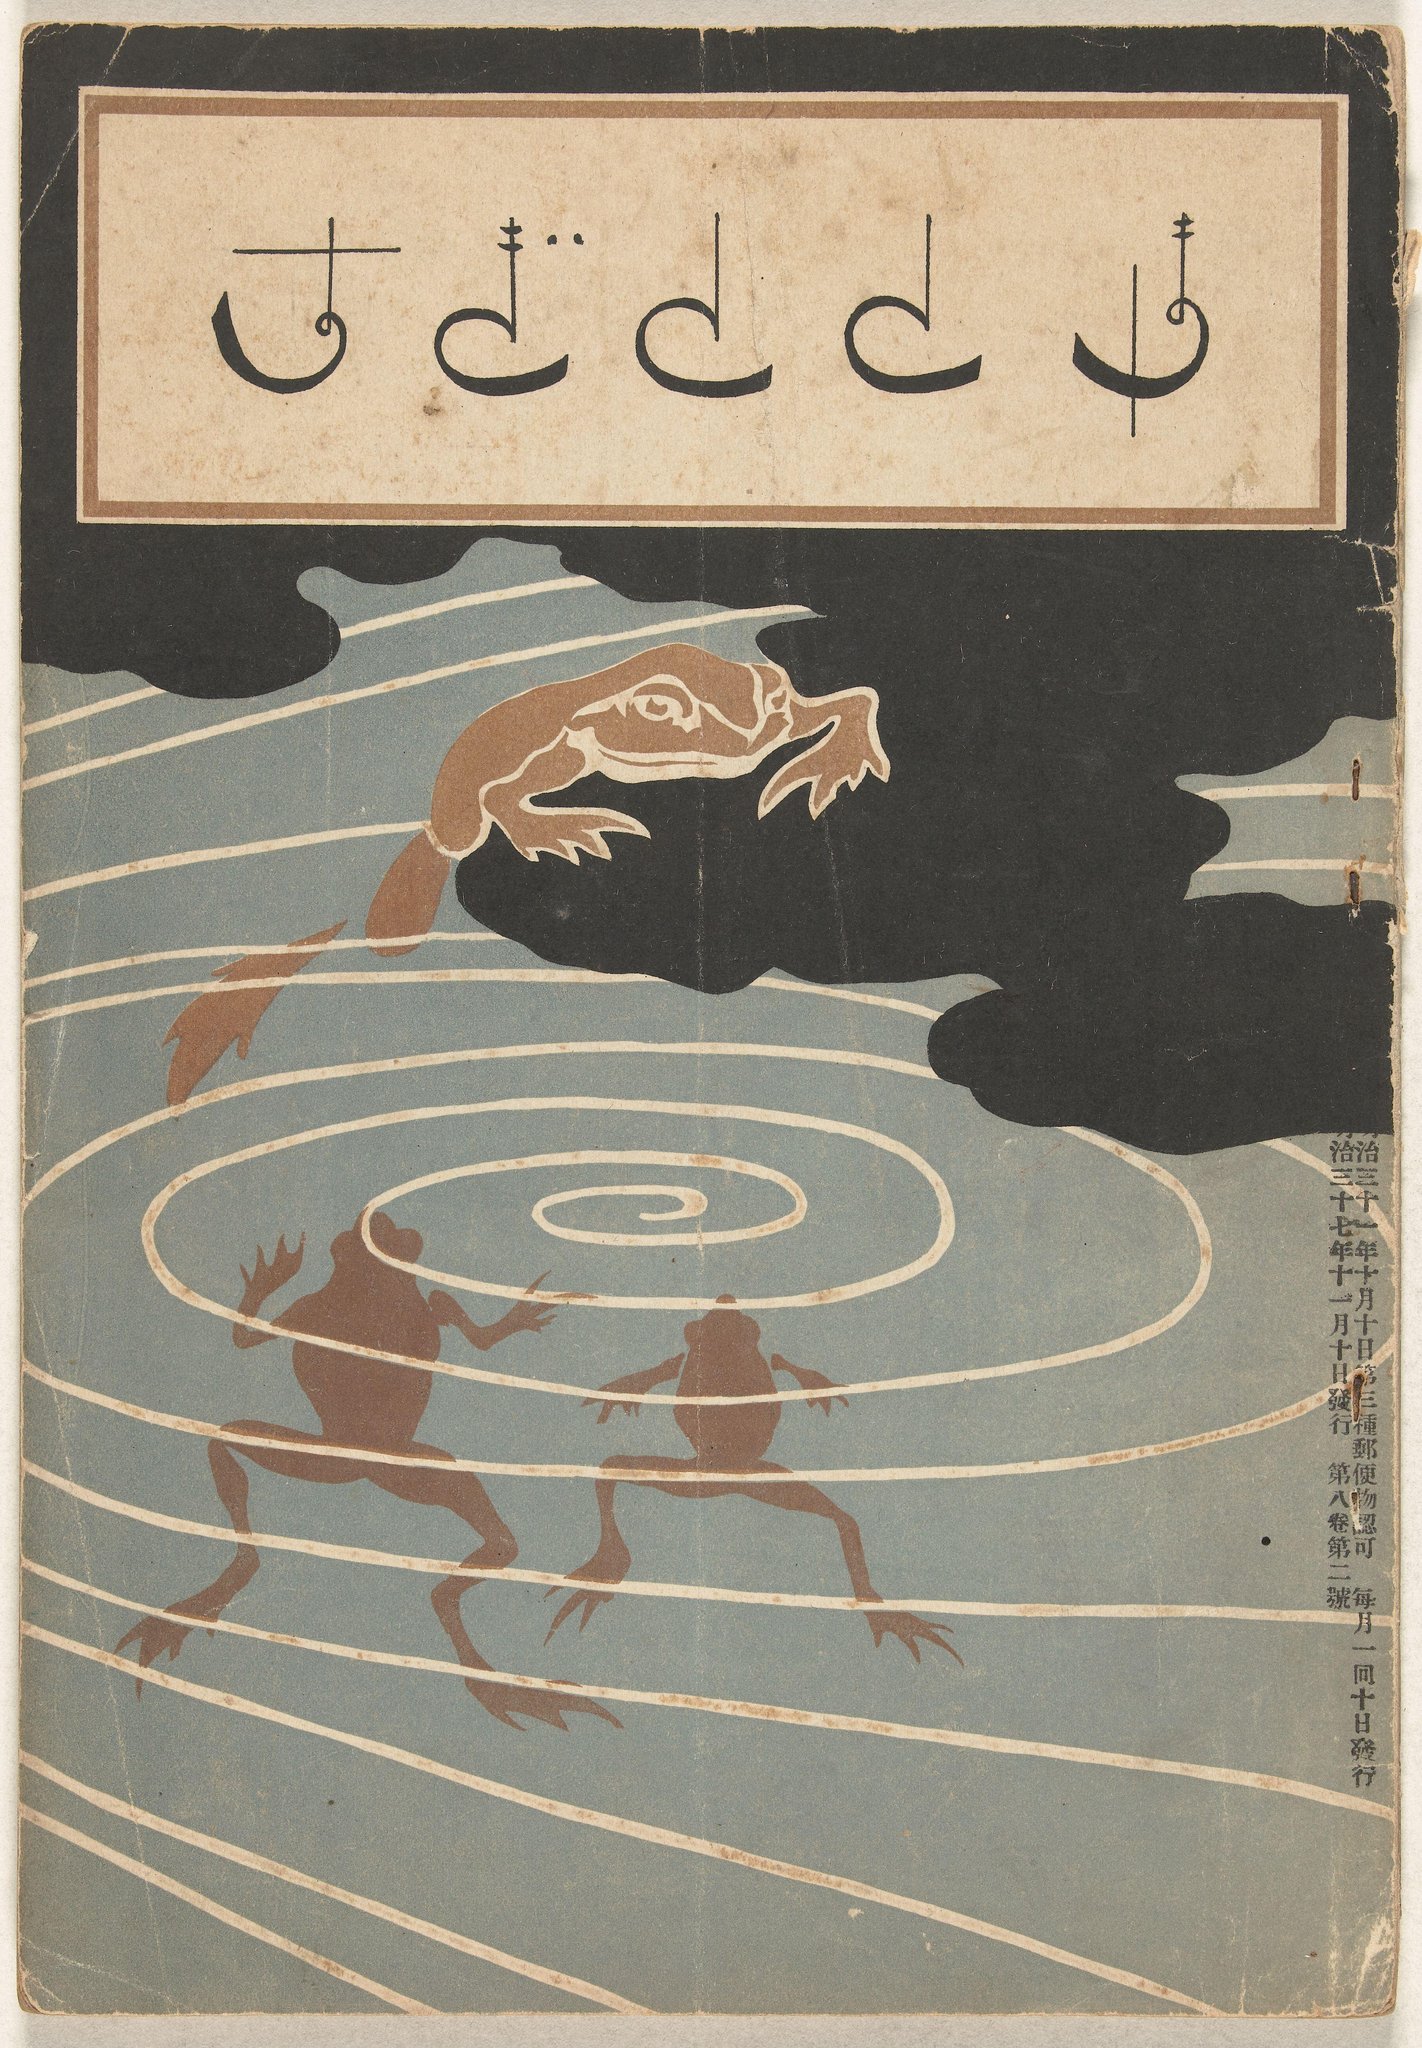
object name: magazine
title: Hototogisu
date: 1904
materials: paper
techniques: woodcut, letterpress printing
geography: japan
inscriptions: date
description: Nummer 2 van jaargang 8 (november 1904) van het literaire maandblad Hototogisu: kaft met bruine kikkers in grijsblauw water en zwarte waterleliebladeren; achterkant, afbeelding van persoon onder tak met herfstbladeren.